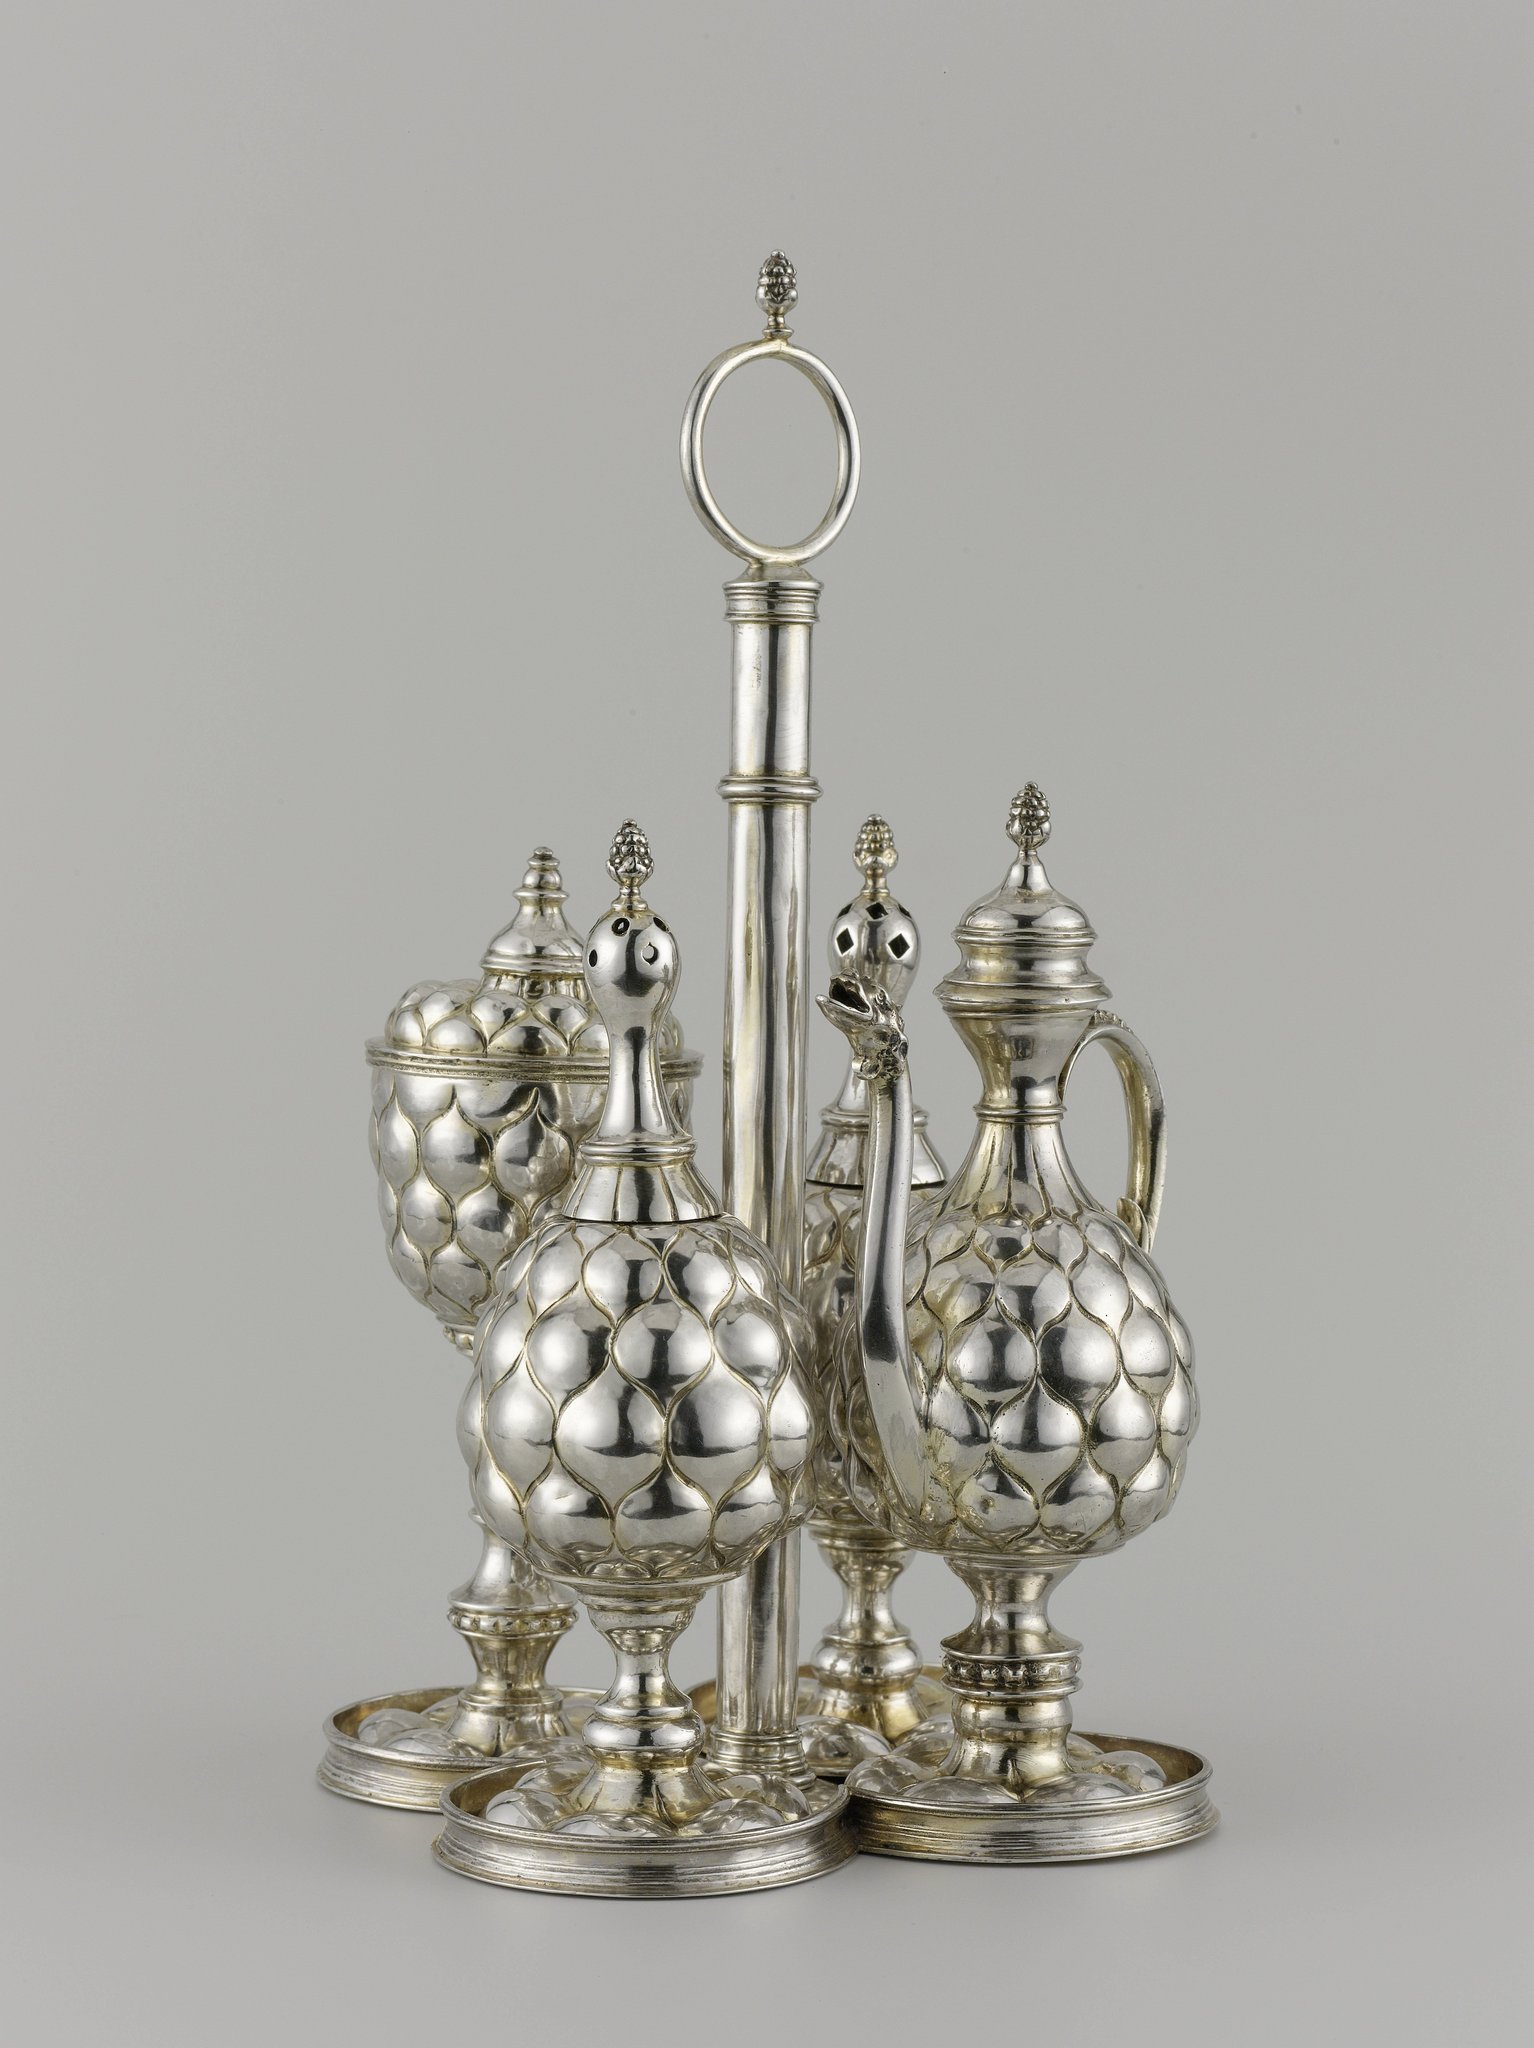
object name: ewer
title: Oliekan, behorend bij een specerijenservies.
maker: anthonie grill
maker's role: silversmith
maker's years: 1607-1675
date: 1642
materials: silver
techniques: casting, gilding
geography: amsterdam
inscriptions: maker's mark: ‘ooievaar tussen AG in ovaal’, date letter: ‘L’, town mark: ‘Amsterdam’